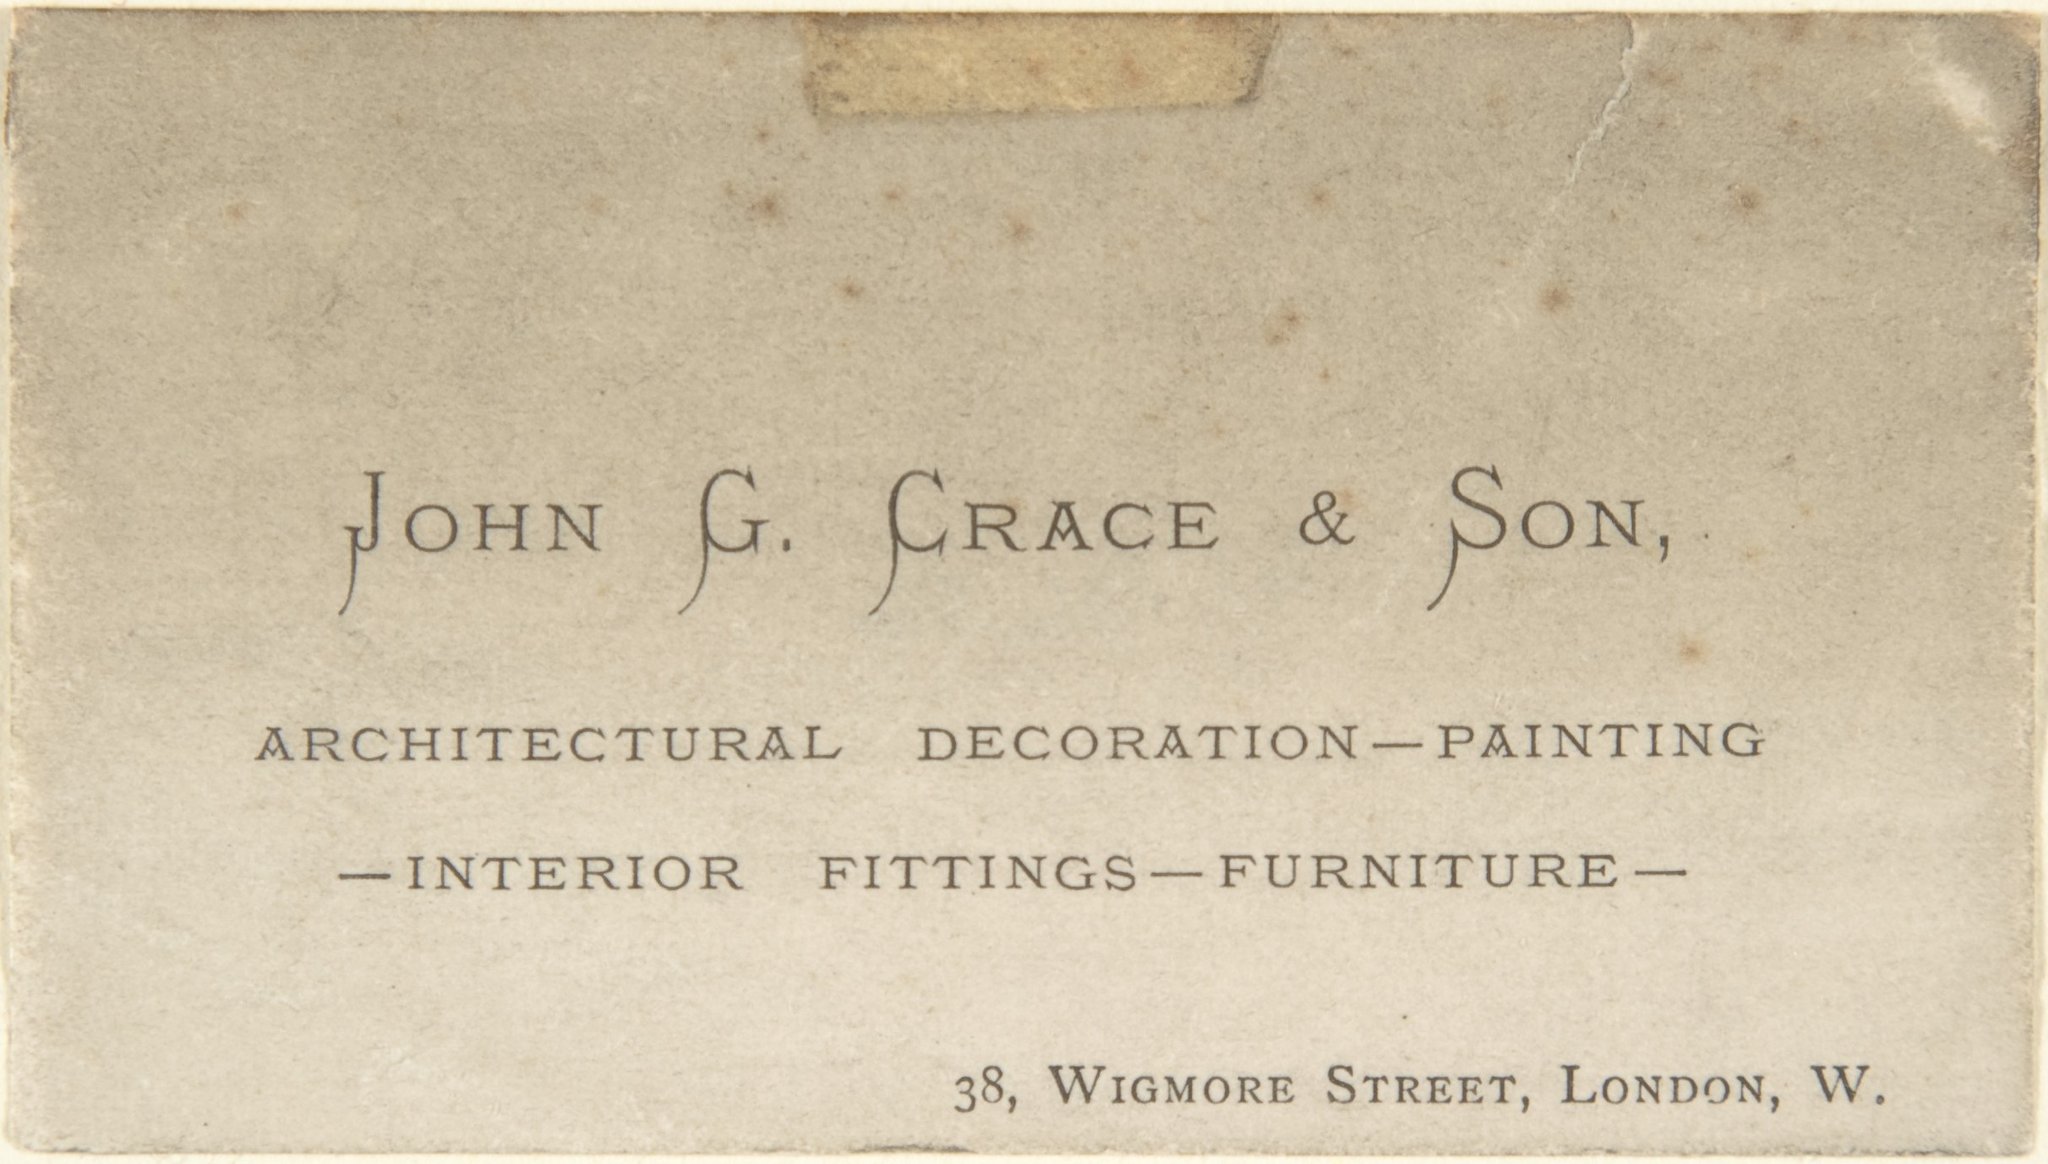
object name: print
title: Business Card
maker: john gregory crace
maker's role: artist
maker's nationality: british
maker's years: 1809-1889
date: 1825-1889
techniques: engraving, printing